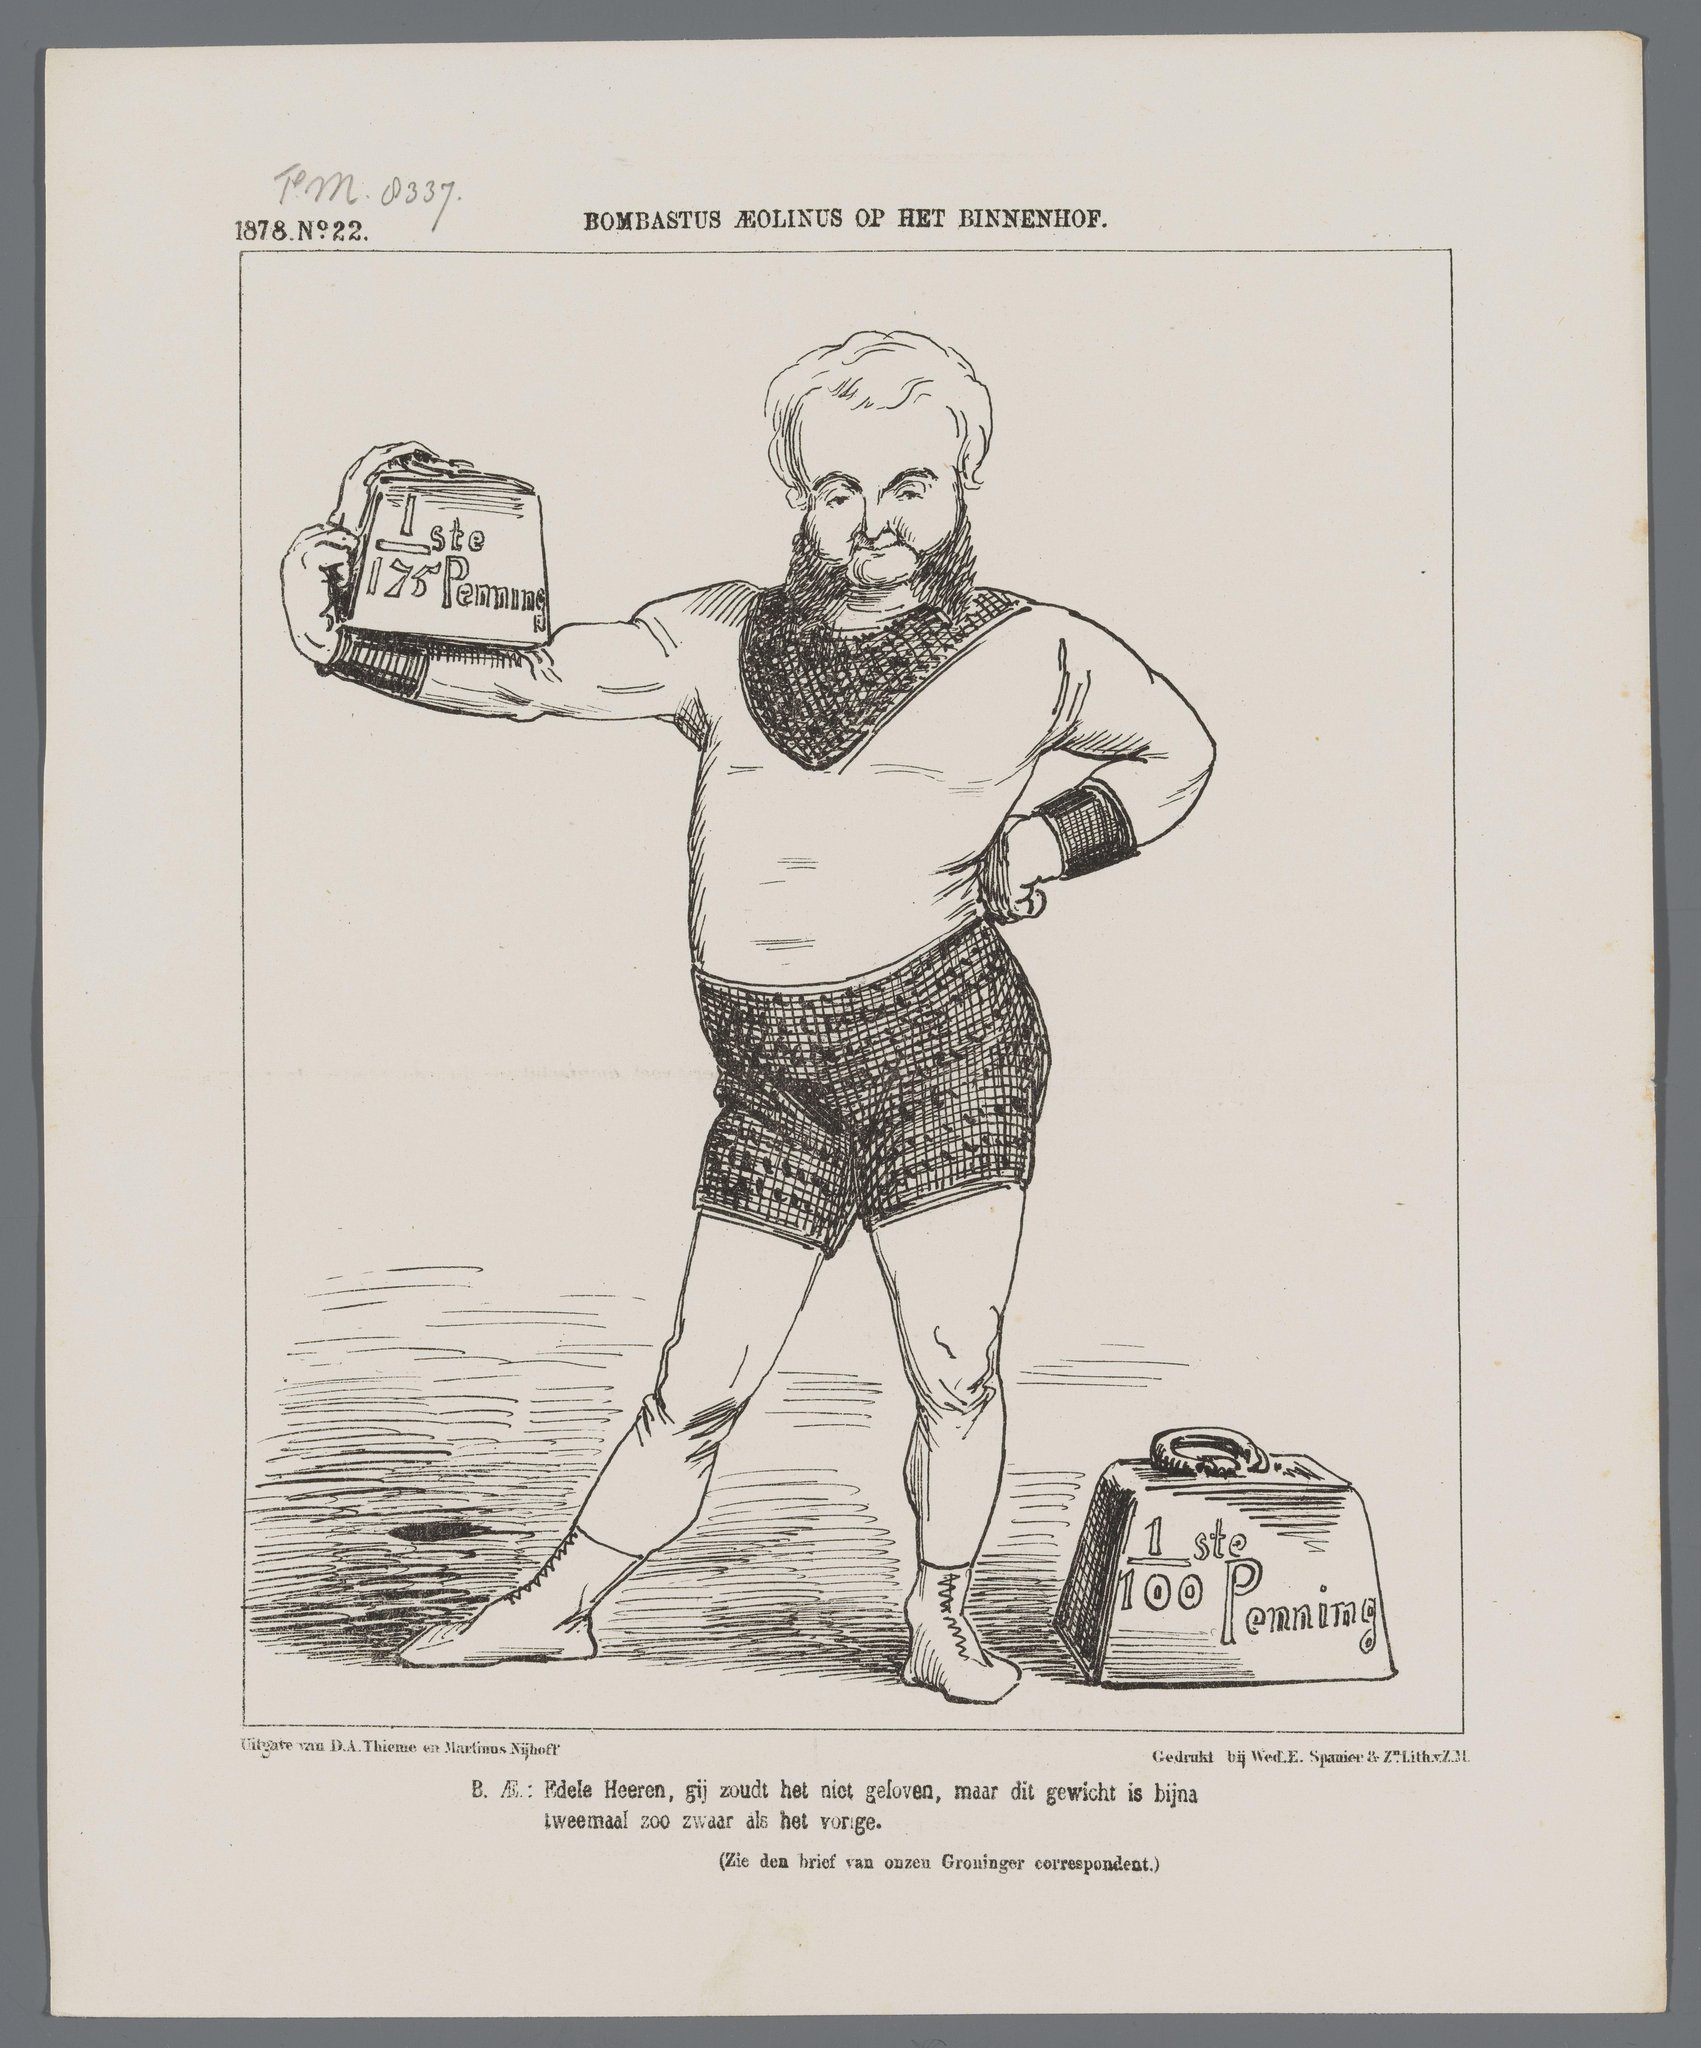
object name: print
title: Spotprent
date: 1878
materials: paper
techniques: lithograph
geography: netherlands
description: Spotprent. Plaat verschenen bij het weekblad De Nederlandsche Spectator, nr. 22, 1878.